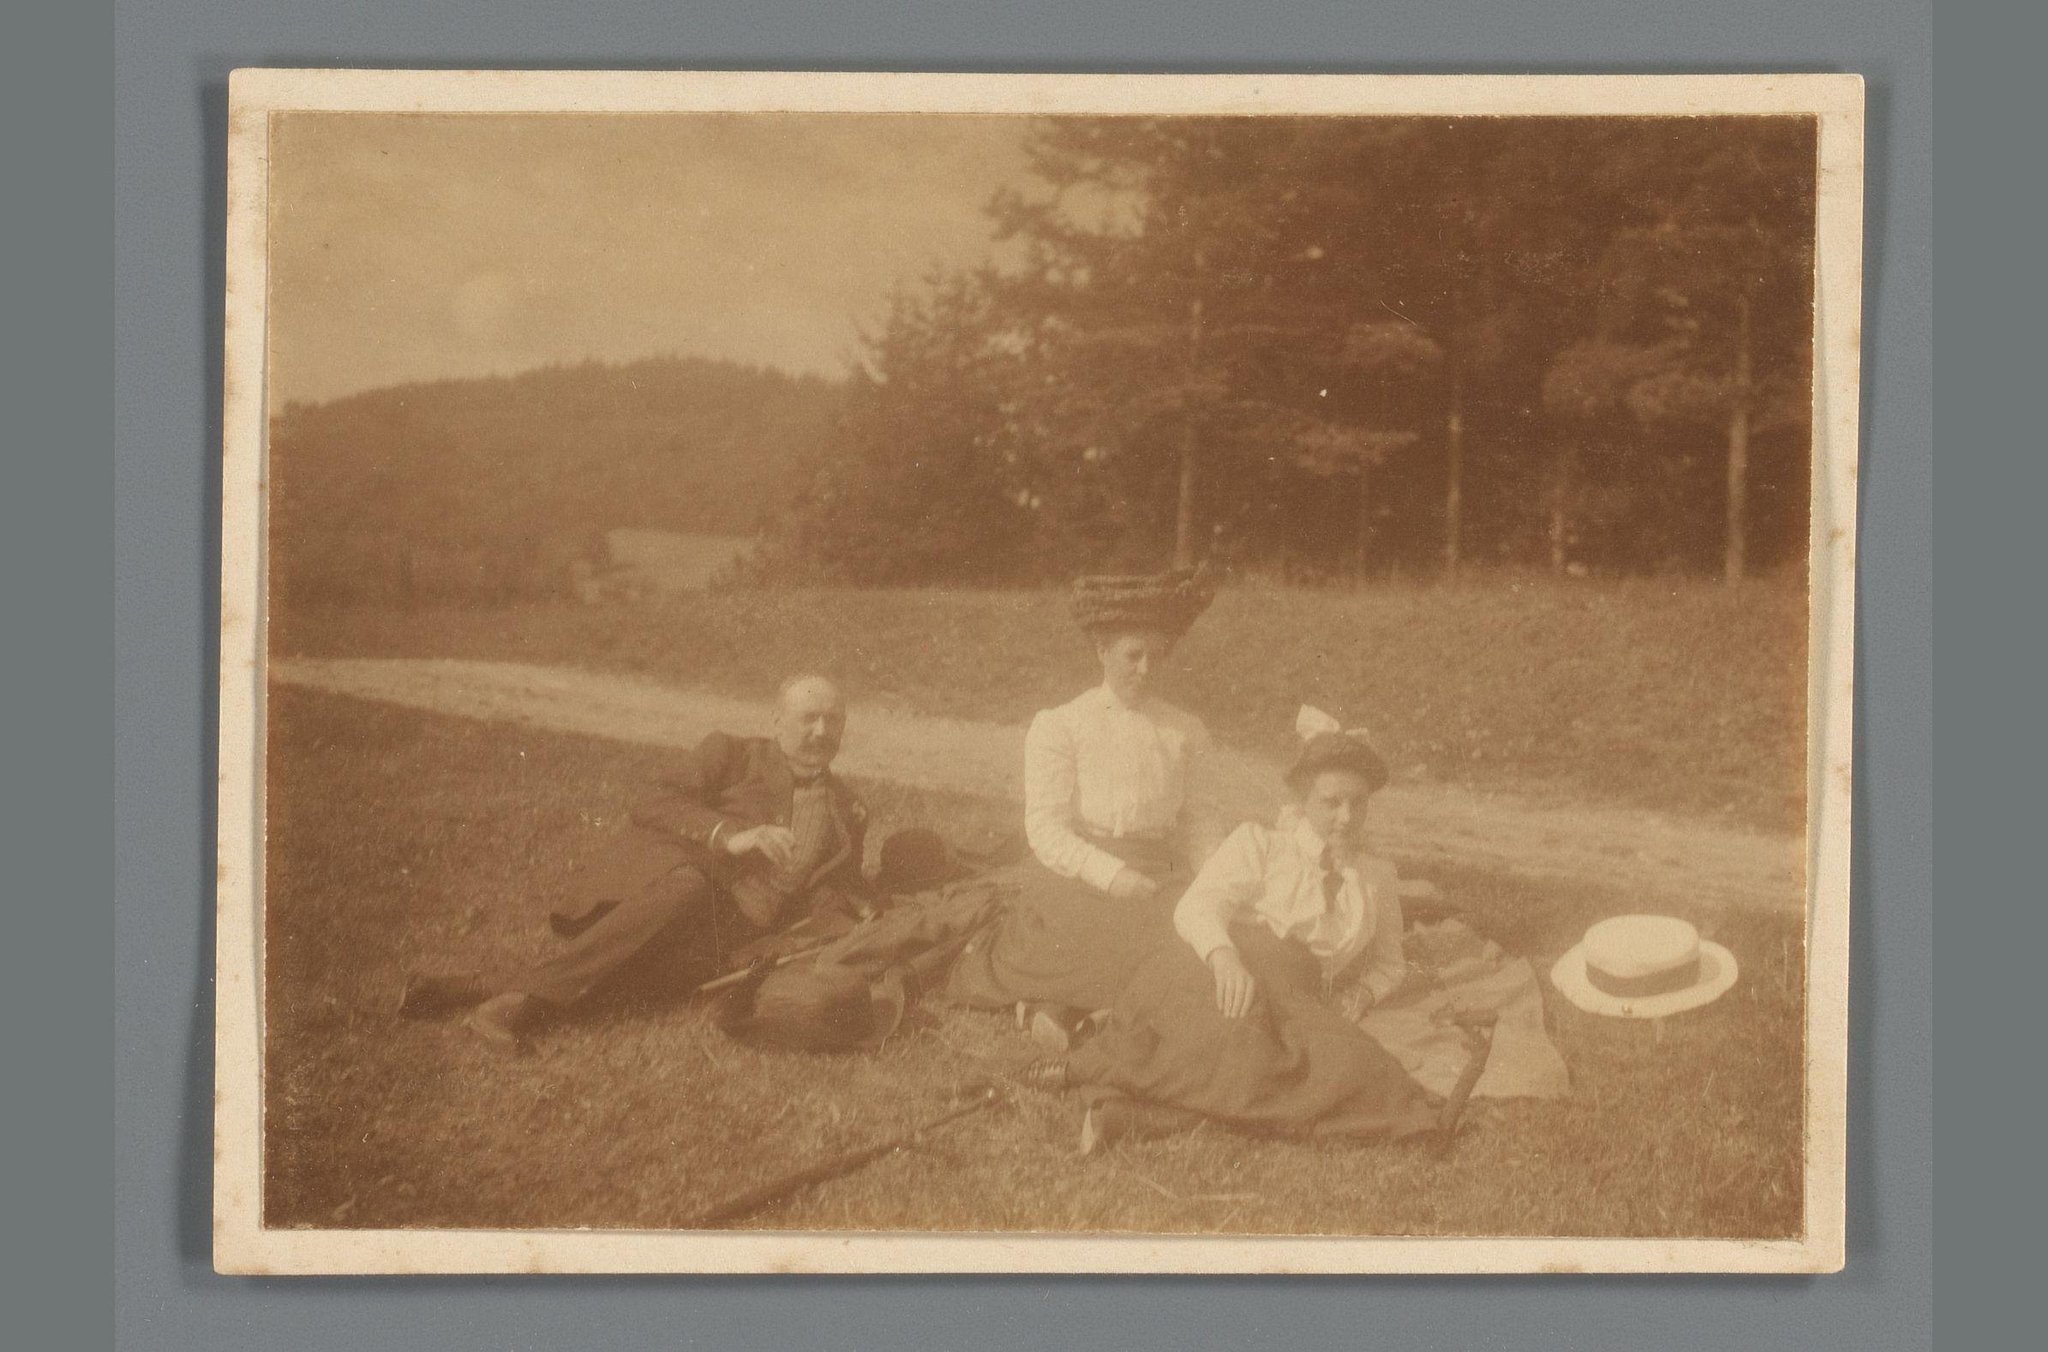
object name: photograph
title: Willem de Jong, Elisabeth de Jong en Johanna (Hans) de Jong liggend in het gras in Kandersteg, Zwitserland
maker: johanna elisabeth borgerhoff mulder-vreede (nan)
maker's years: 1891-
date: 1914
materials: paper, cardboard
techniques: collodion silver print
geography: switzerland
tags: haarlem, elisabeth de jong-van tonderen, leiden, johanna petronella lambertina stokhuyzen-de jong (hans), willem de jong (fotograaf), historical persons, resting - bb - out of doors